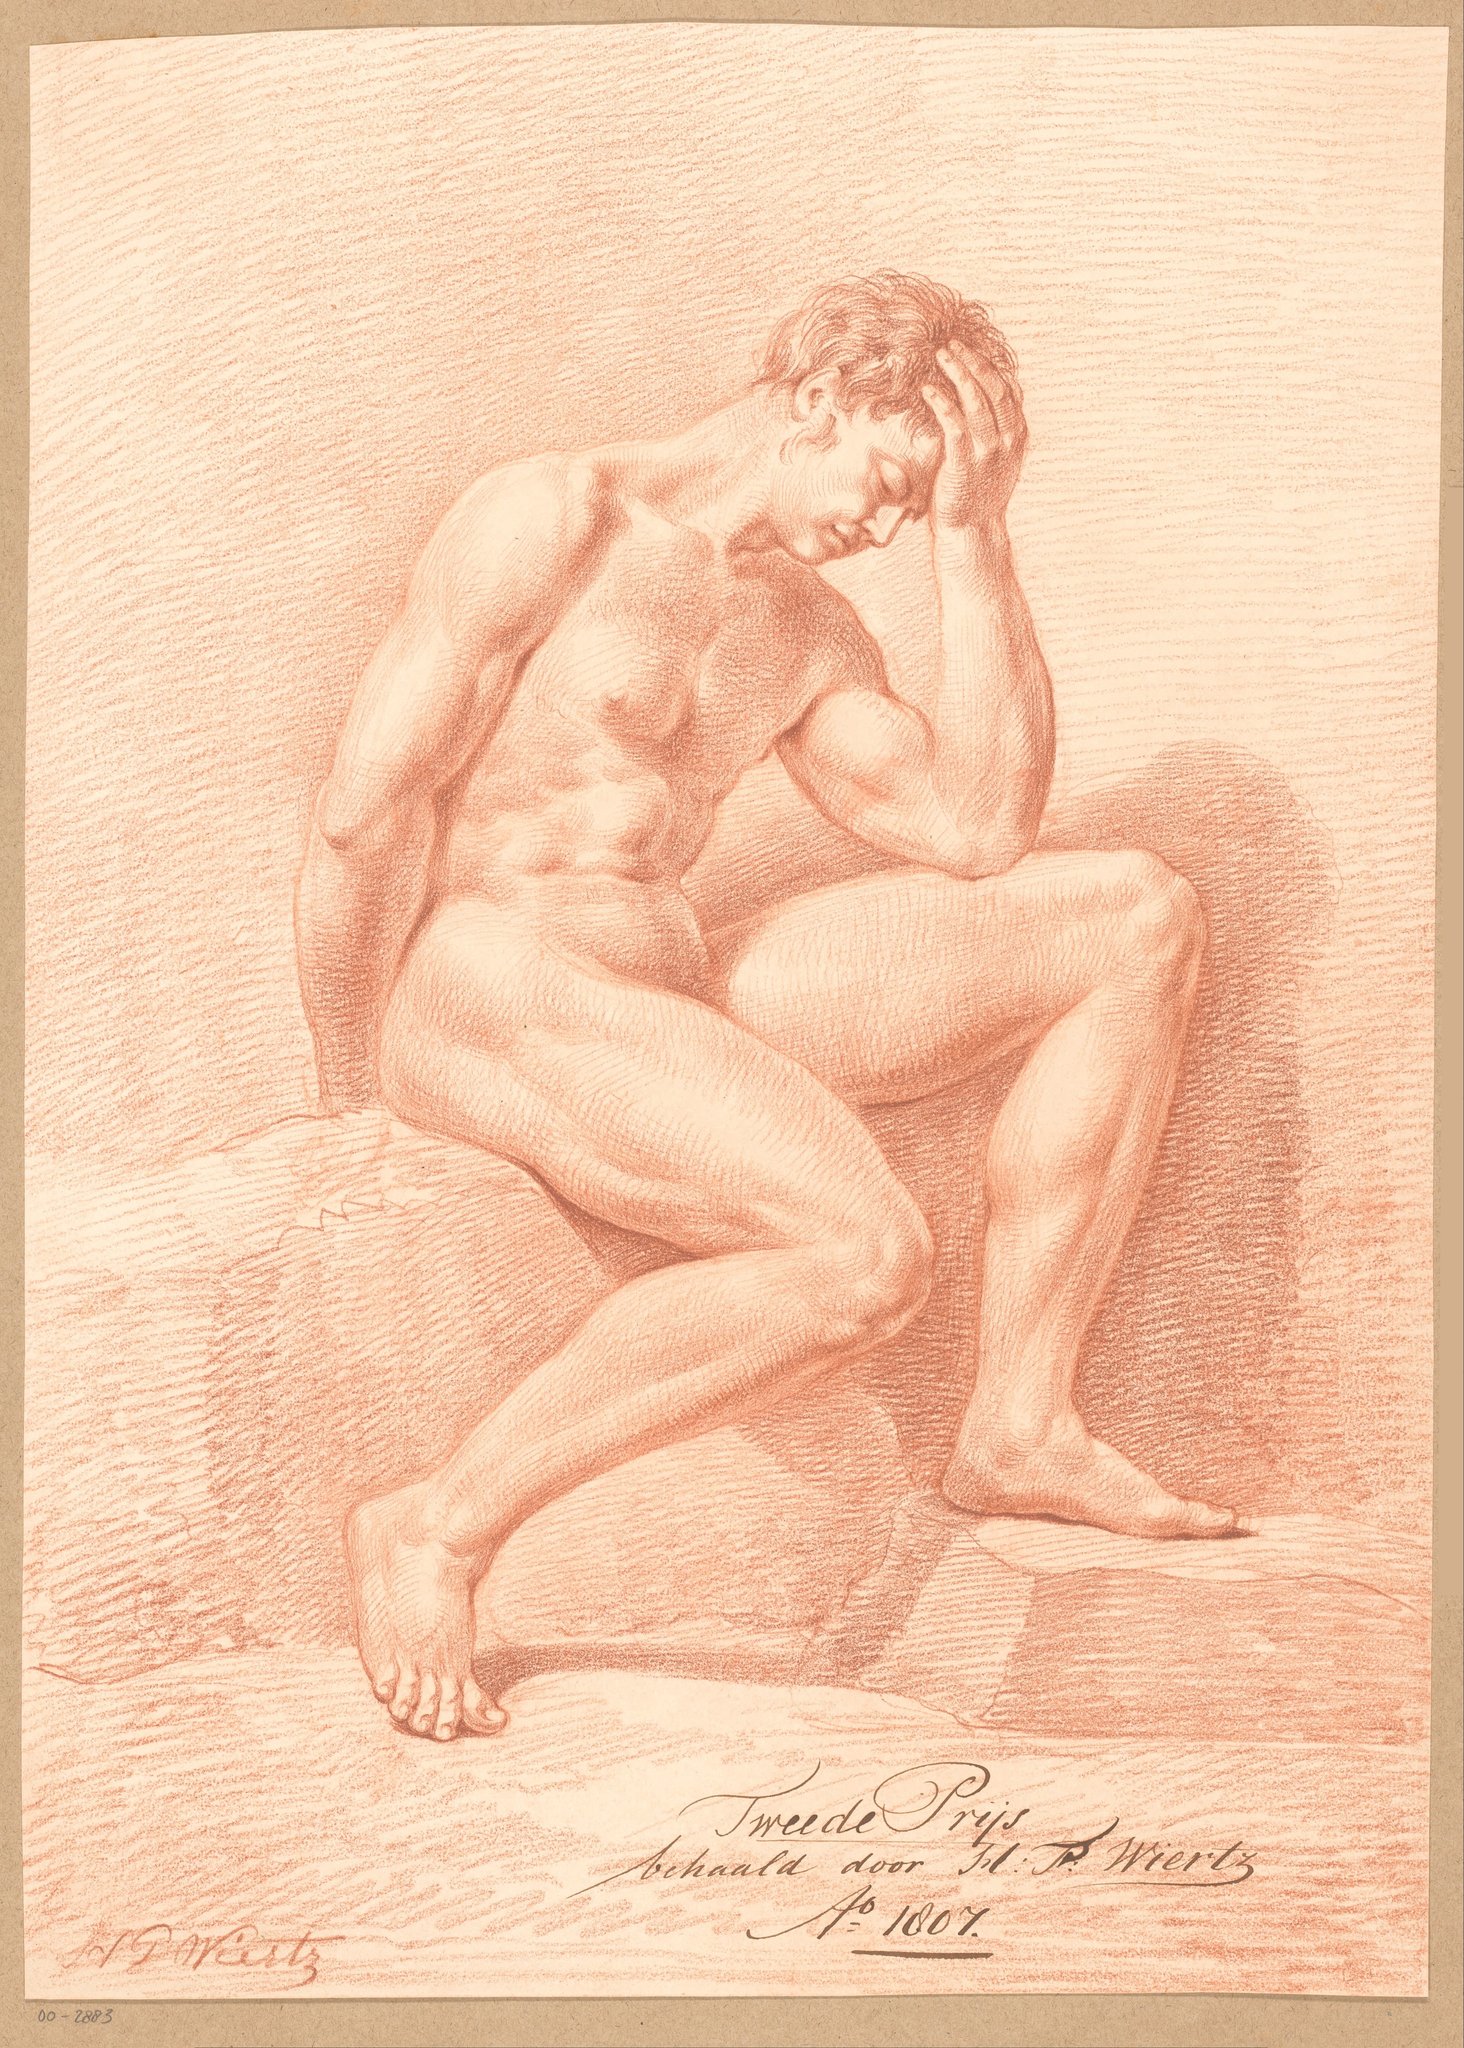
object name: drawing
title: Zittend mannelijk naakt, van opzij gezien (2e prijs 1807)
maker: henricus franciscus wiertz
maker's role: draughtsman, painter, print maker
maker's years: 1784-1858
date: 1807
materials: chalk, paper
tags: sitting figure (+ nude human being)